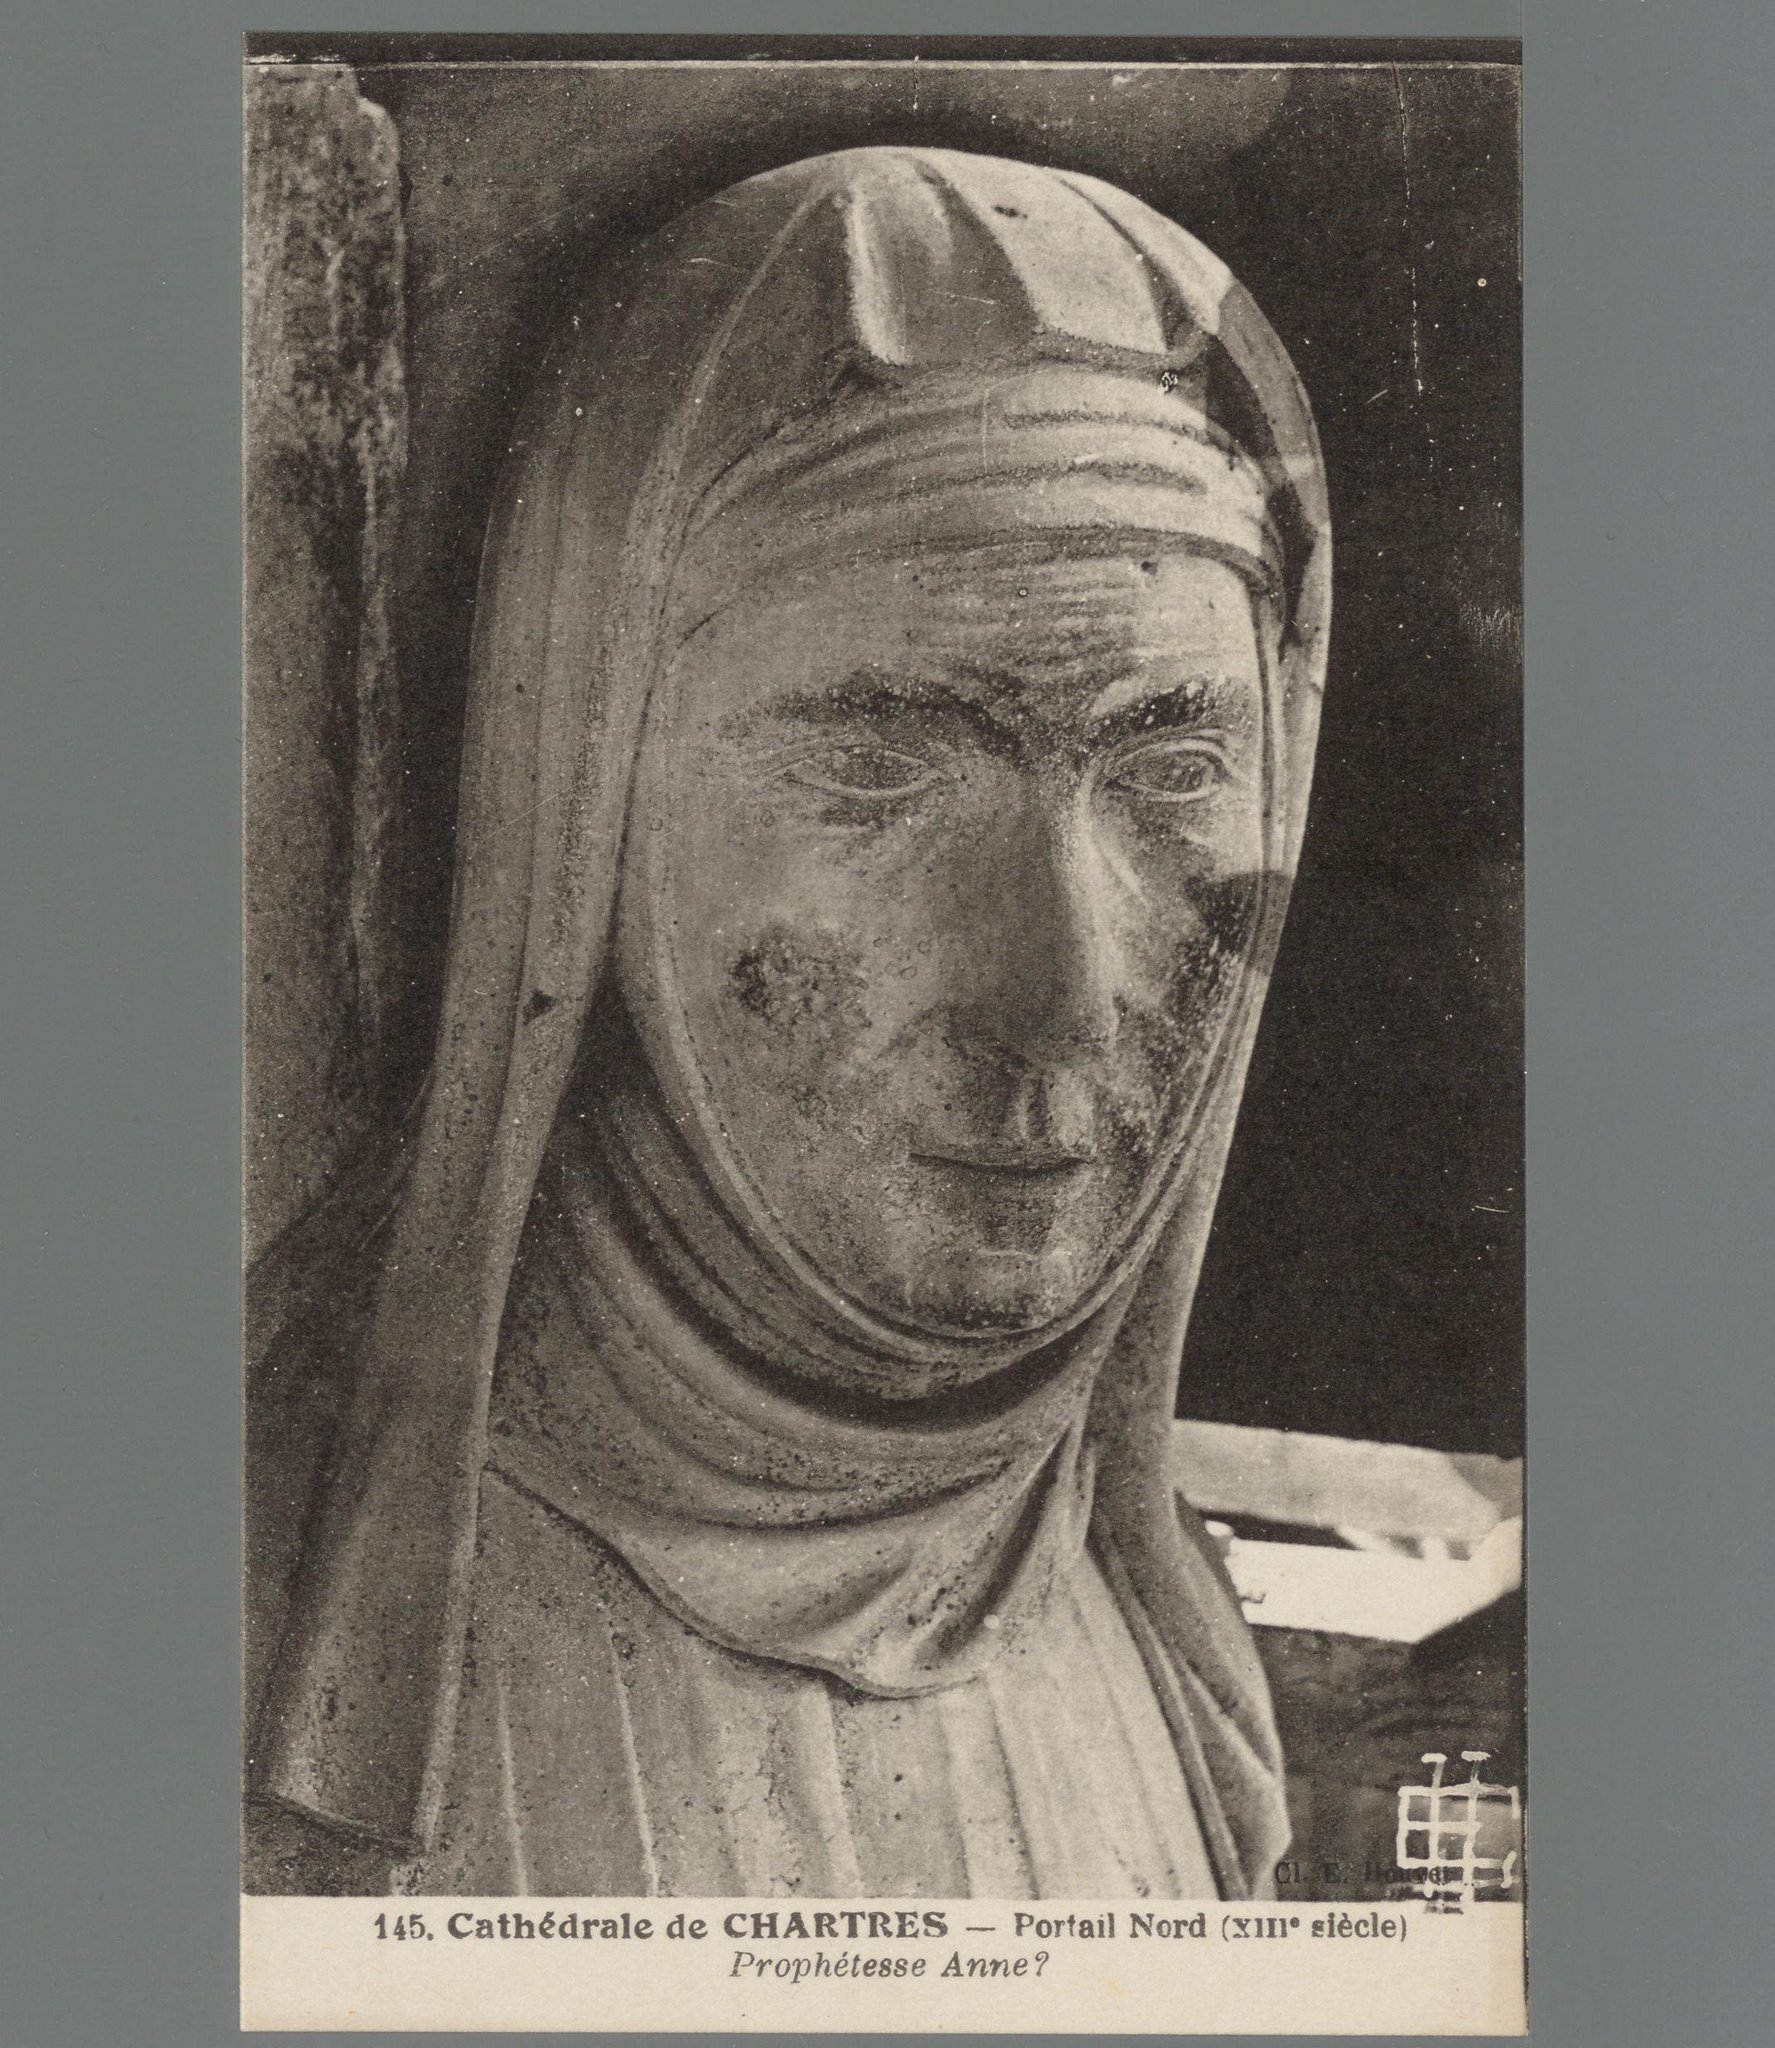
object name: ansichtkaart, prentbriefkaart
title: Cathédrale de Chartres - Portail Nord (XIIIe siècle). Prophétesse Anne?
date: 1903-1930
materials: cardboard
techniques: photograph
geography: chartres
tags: church (exterior), statues, paintings, etc. ~ objects of worship in roman religion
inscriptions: collector's mark: ‘AFE v S’, monogram: ‘EH’